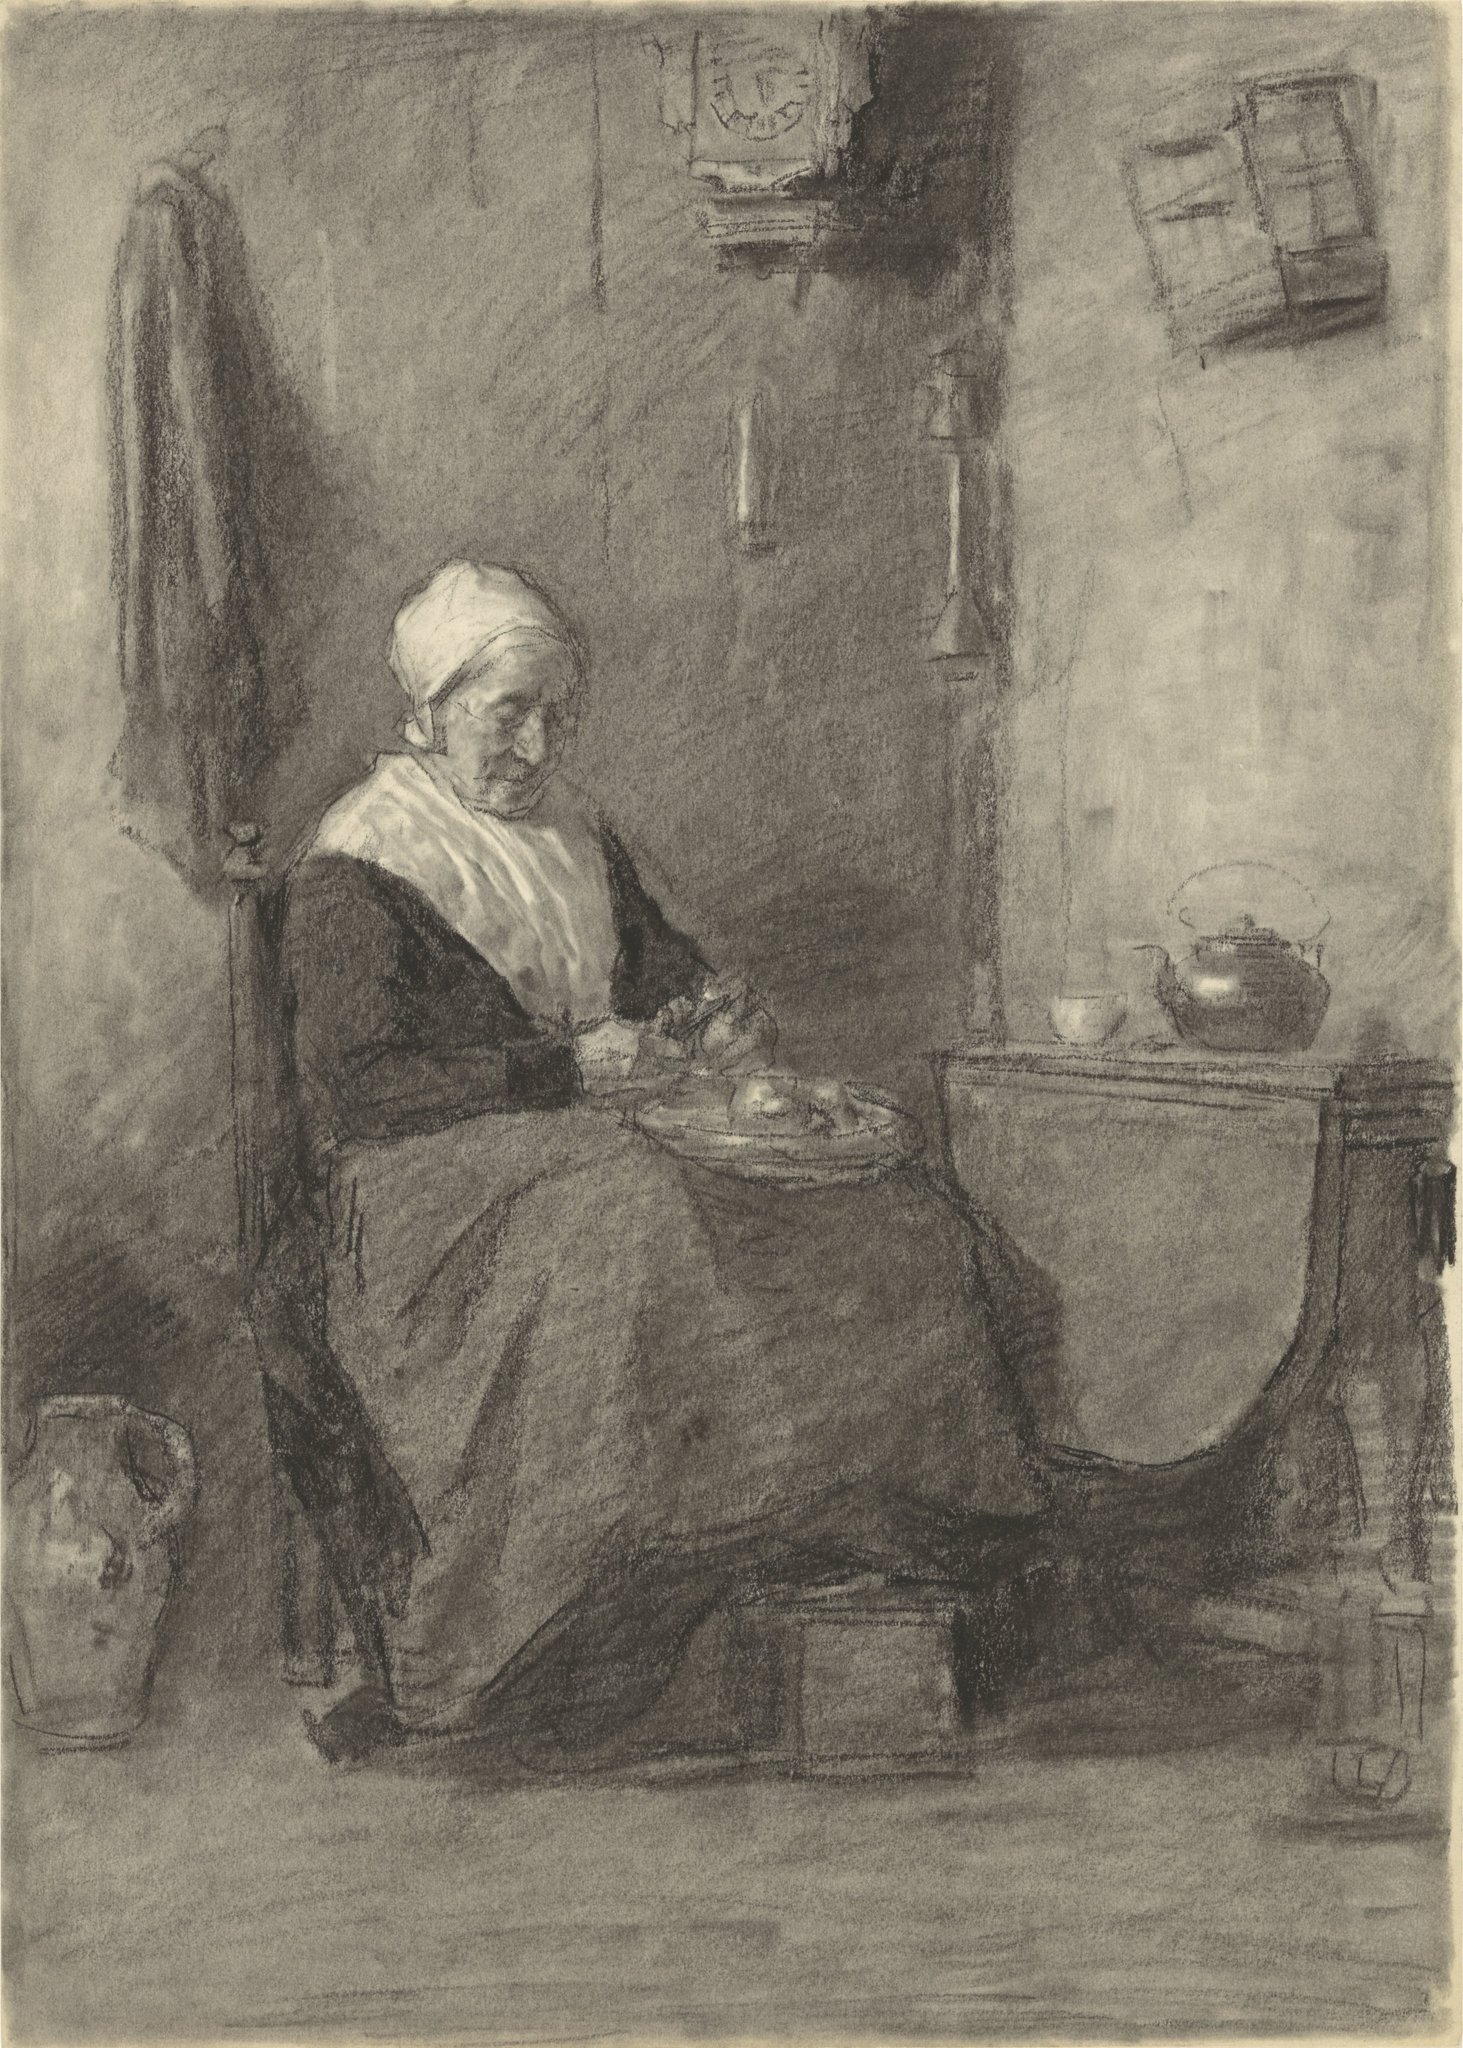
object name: drawing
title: Boerenvrouw in interieur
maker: johan antonie de jonge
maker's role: draughtsman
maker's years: 1864-1927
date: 1885-1927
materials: chalk, paper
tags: farmers - aa - female farmer, farmer's wife, old woman, cleaning vegetables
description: De huidige titel is door het Rijksmuseum overgenomen van het Instituut Collectie Nederland.